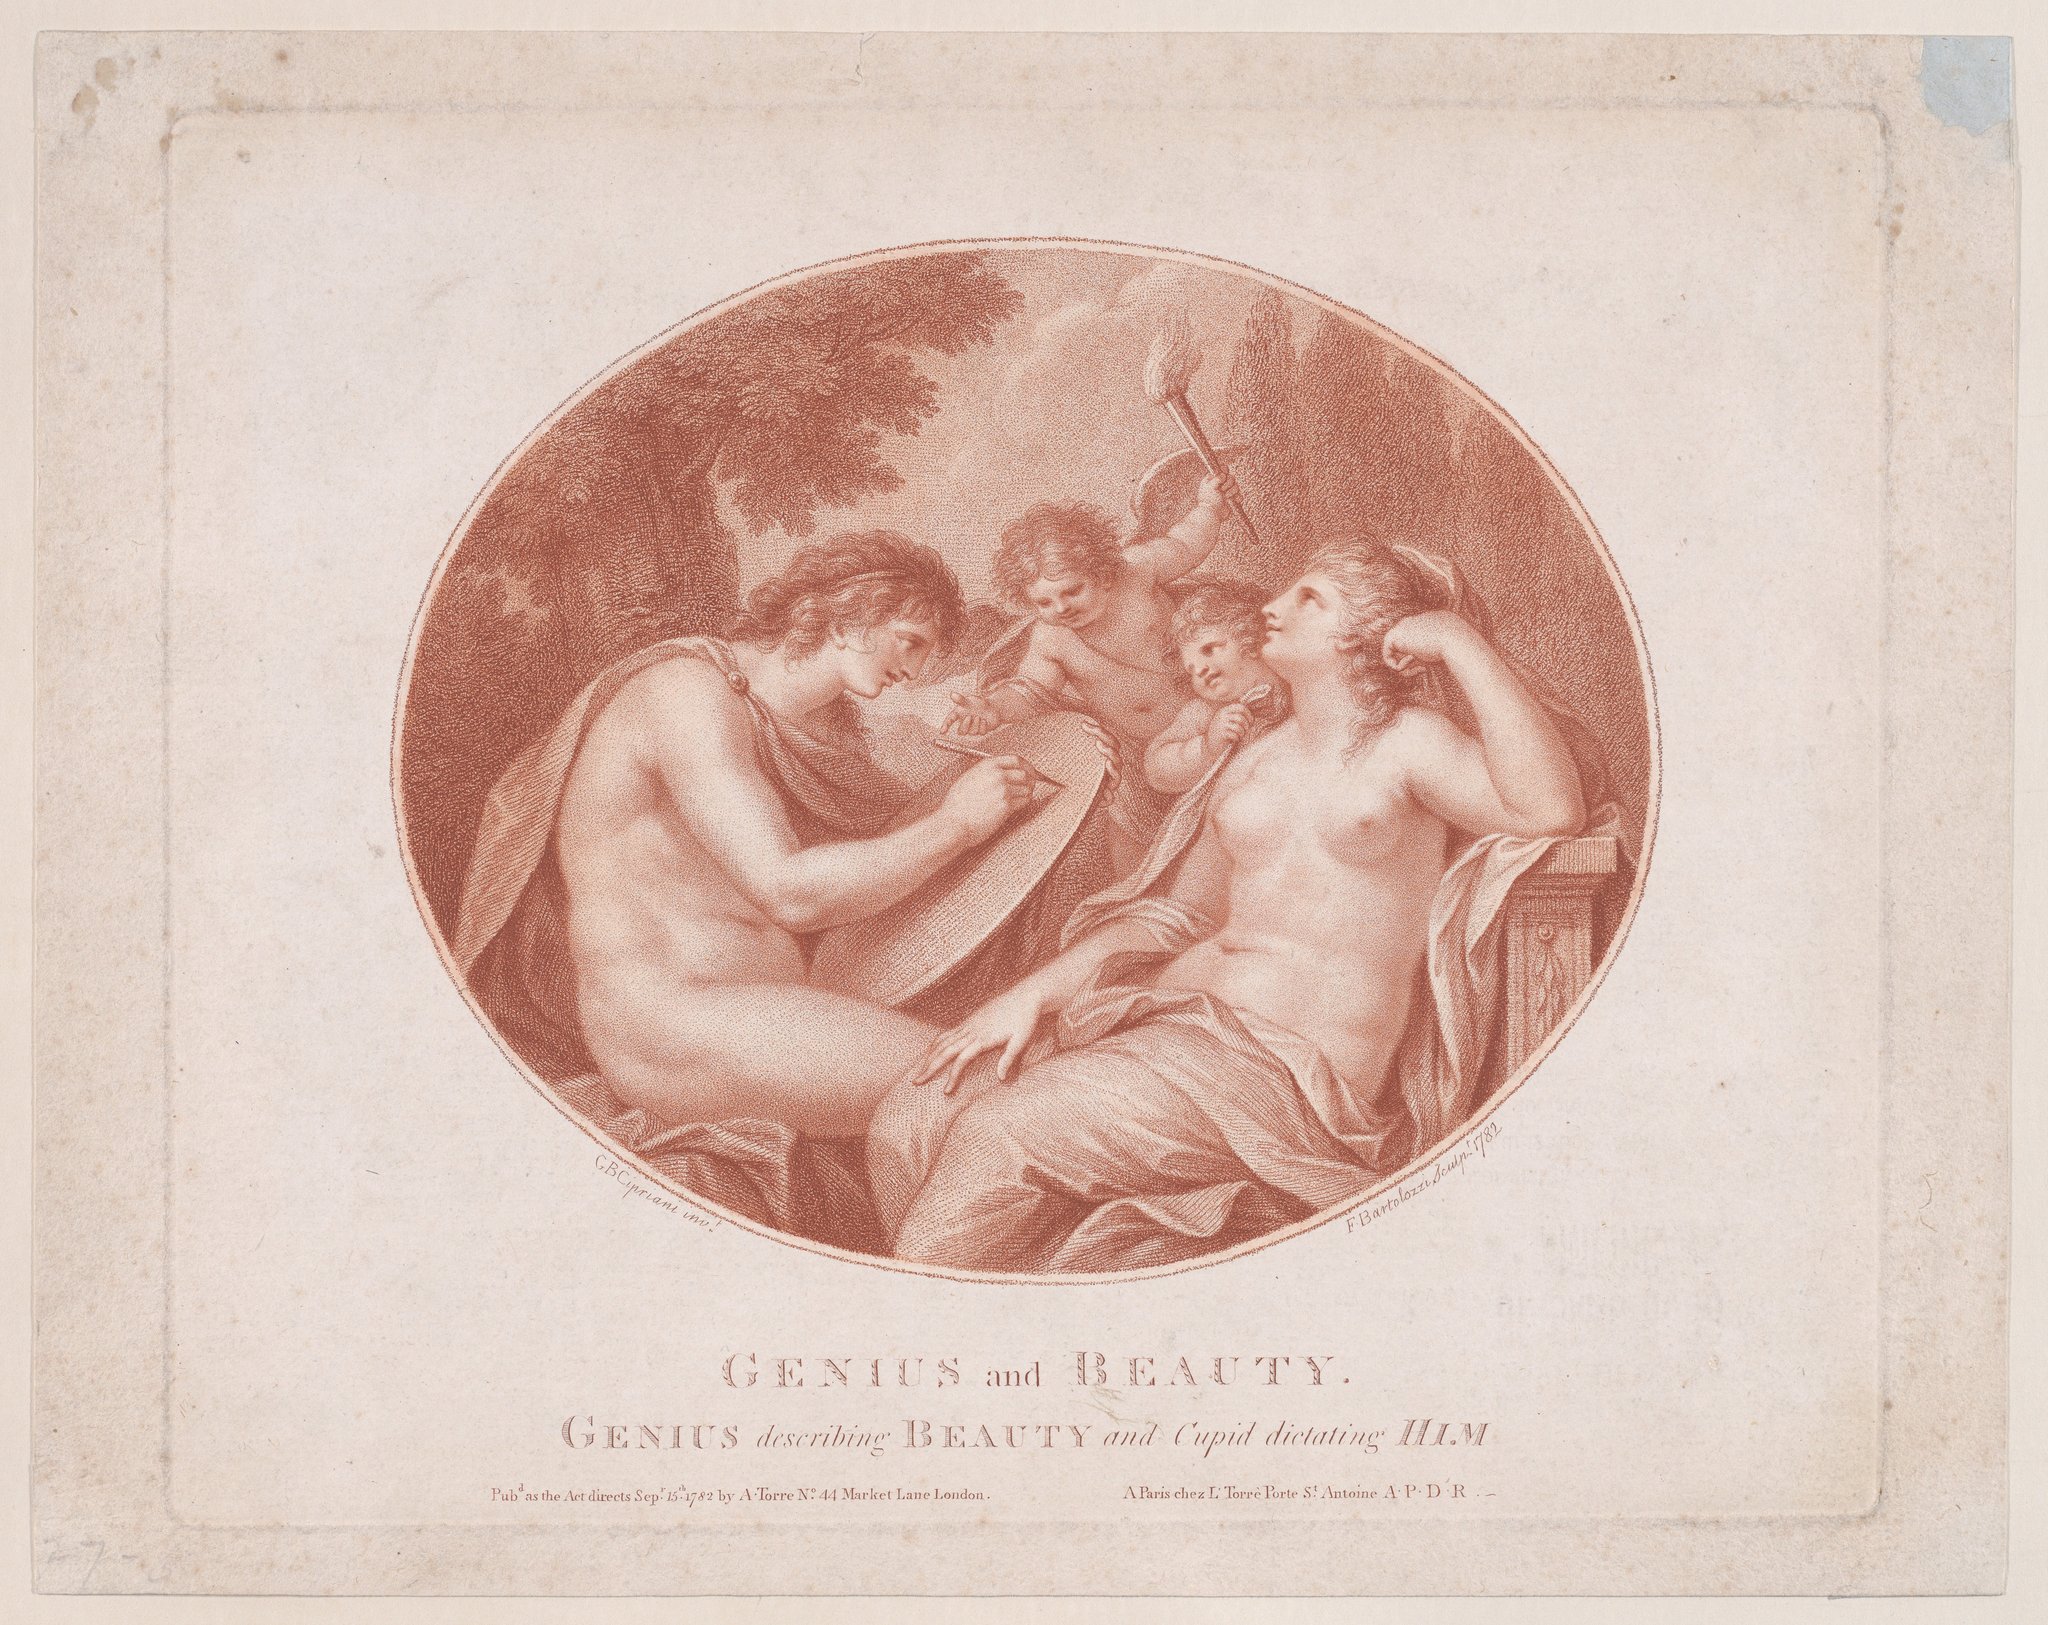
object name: print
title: Genius and Beauty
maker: francesco bartolozzi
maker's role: artist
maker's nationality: italian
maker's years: 1728-1815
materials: ink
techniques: etching, printing, engraving